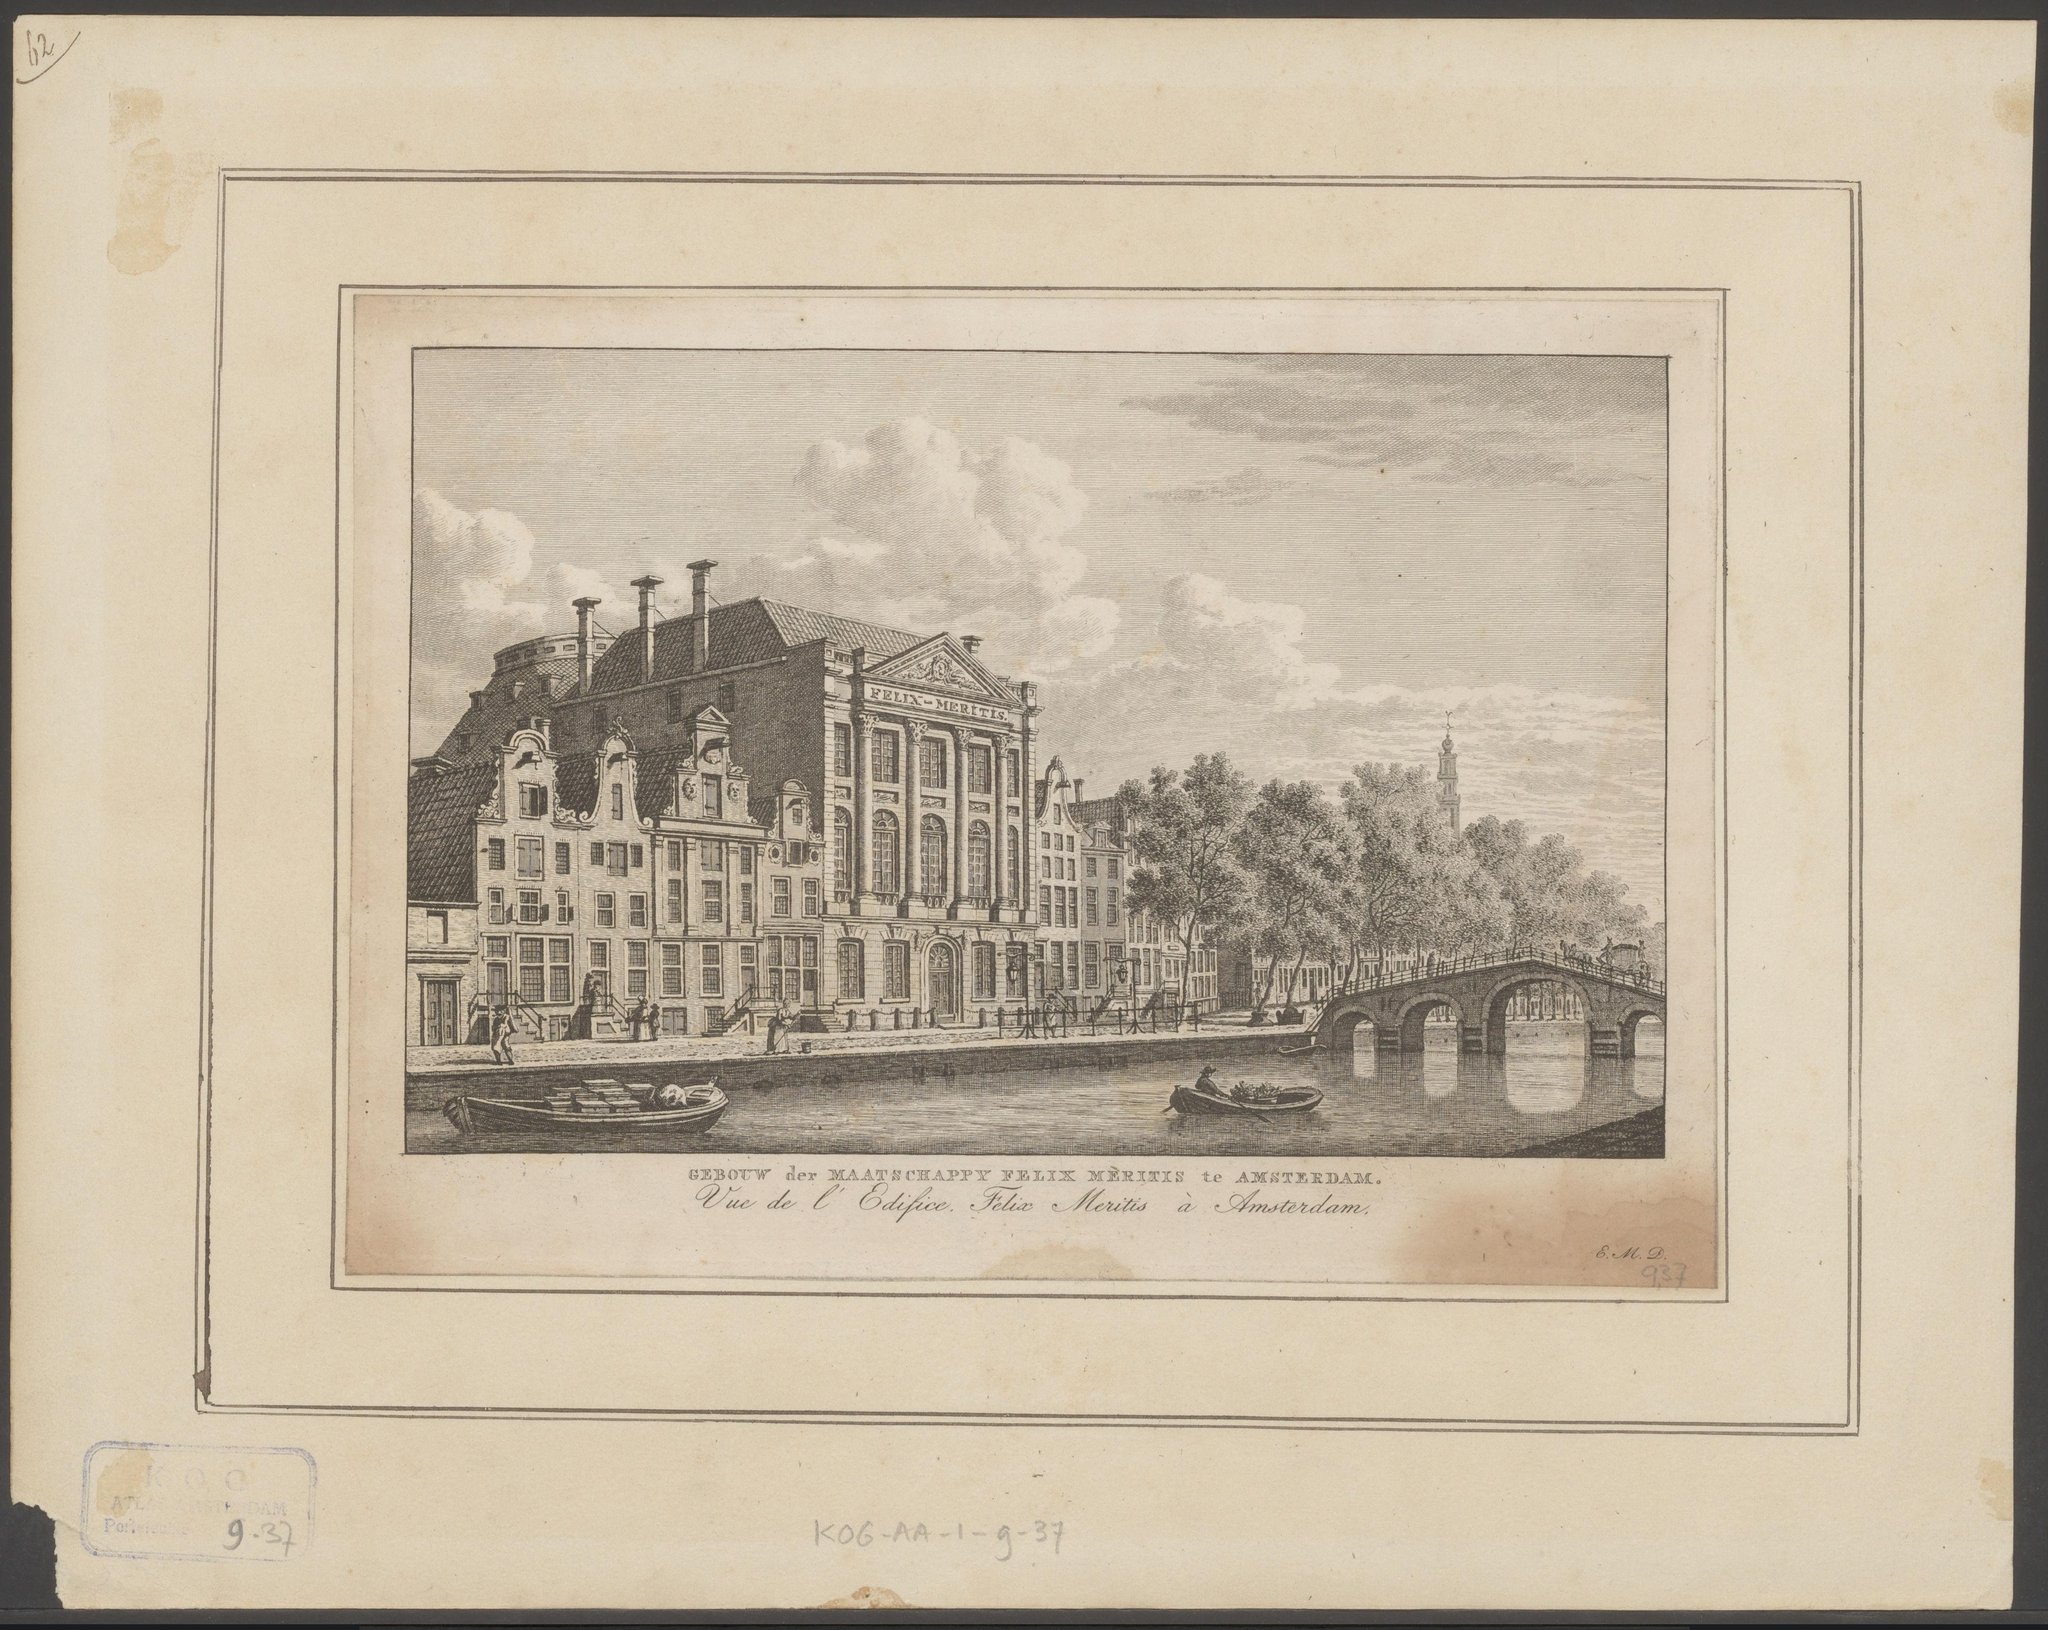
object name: print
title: Gezicht op het gebouw Felix Meritis te Amsterdam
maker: carel frederik bendorp (i)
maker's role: print maker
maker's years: 1736-1814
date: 1786-1792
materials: paper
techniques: etching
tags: city-view in general; 'veduta', canal, façade (of house or building), bridge in city across river, canal, etc.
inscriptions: collector's mark: ‘9,37’ Lugt 1641b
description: Huidige staat van prent uitgegeven als onderdeel van een plaatwerk uit ca. 1824-1825 met 74 (ongenummerde) platen van de belangrijkste topografische gezichten en verschillende zeden en gewoonten in het Verenigd Koninkrijk der Nederlanden, getiteld 'Tableau des principales vues des palais et édifices : représentations et des coutumes et usages, dans les provinces septentrionales du Royaume des Pays-Bas'. Eerdere staat gebruikt in: Vaderlandsche gezichten, of afbeeldingen van den tegenwoordigen staat der Vereenigde Nederlanden (…). Amsterdam: Hendrik Gartman, Willem Vermandel en Jan Willem Smit, 1786-1792. Uitgegeven in afleveringen met ieder een eigen bifolium en inhoudsopgave. Alle prenten in deze publicatie zijn gegraveerd door Carel Frederik Bendorp (I) en, in de meeste gevallen, gebaseerd op tekeningen van Jan Bulthuis.